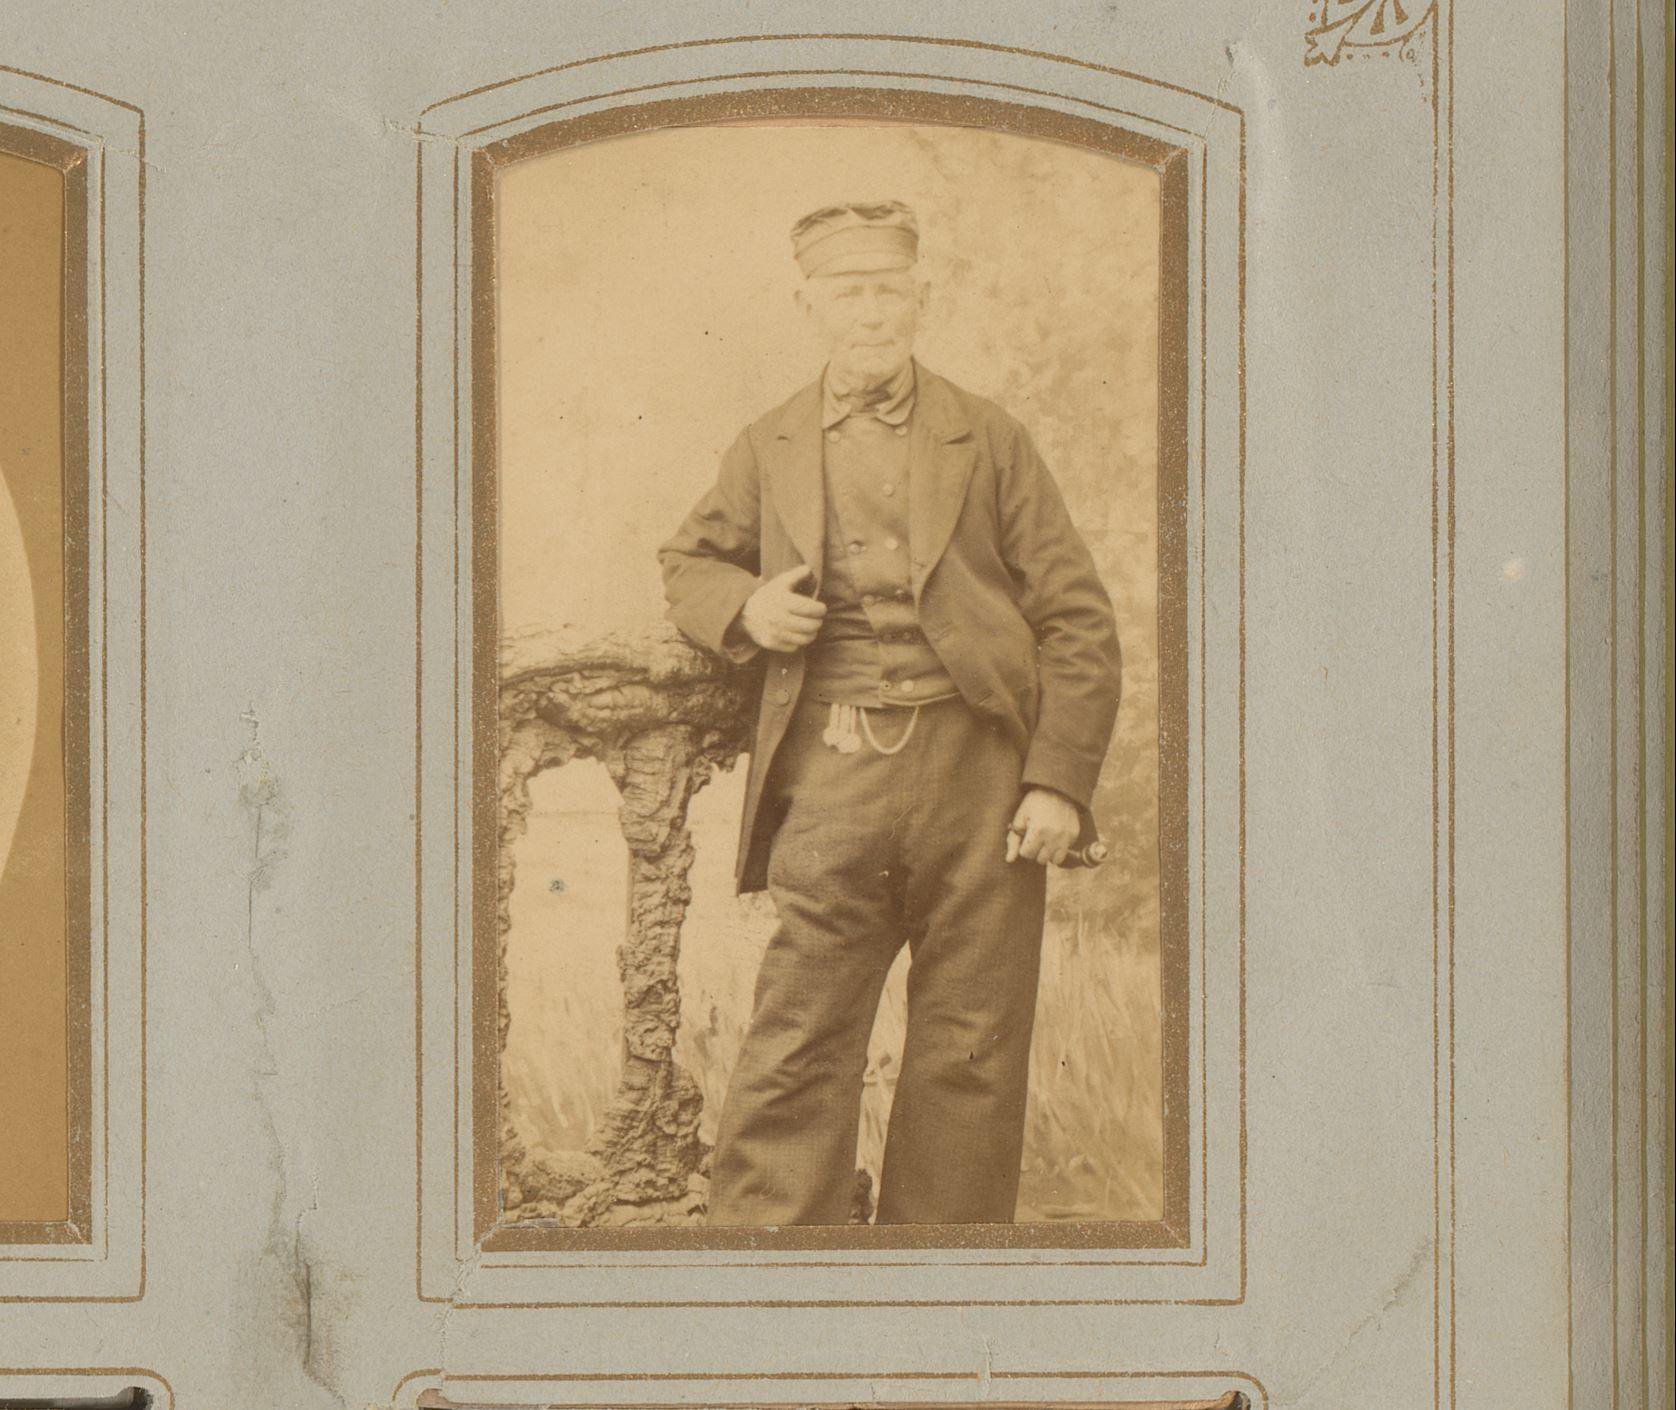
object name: photograph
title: Portret van oude man, leunend op een balustrade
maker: Anonymous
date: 1850-1900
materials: cardboard, photographic support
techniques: albumen print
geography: netherlands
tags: historical persons, old man, balustrade